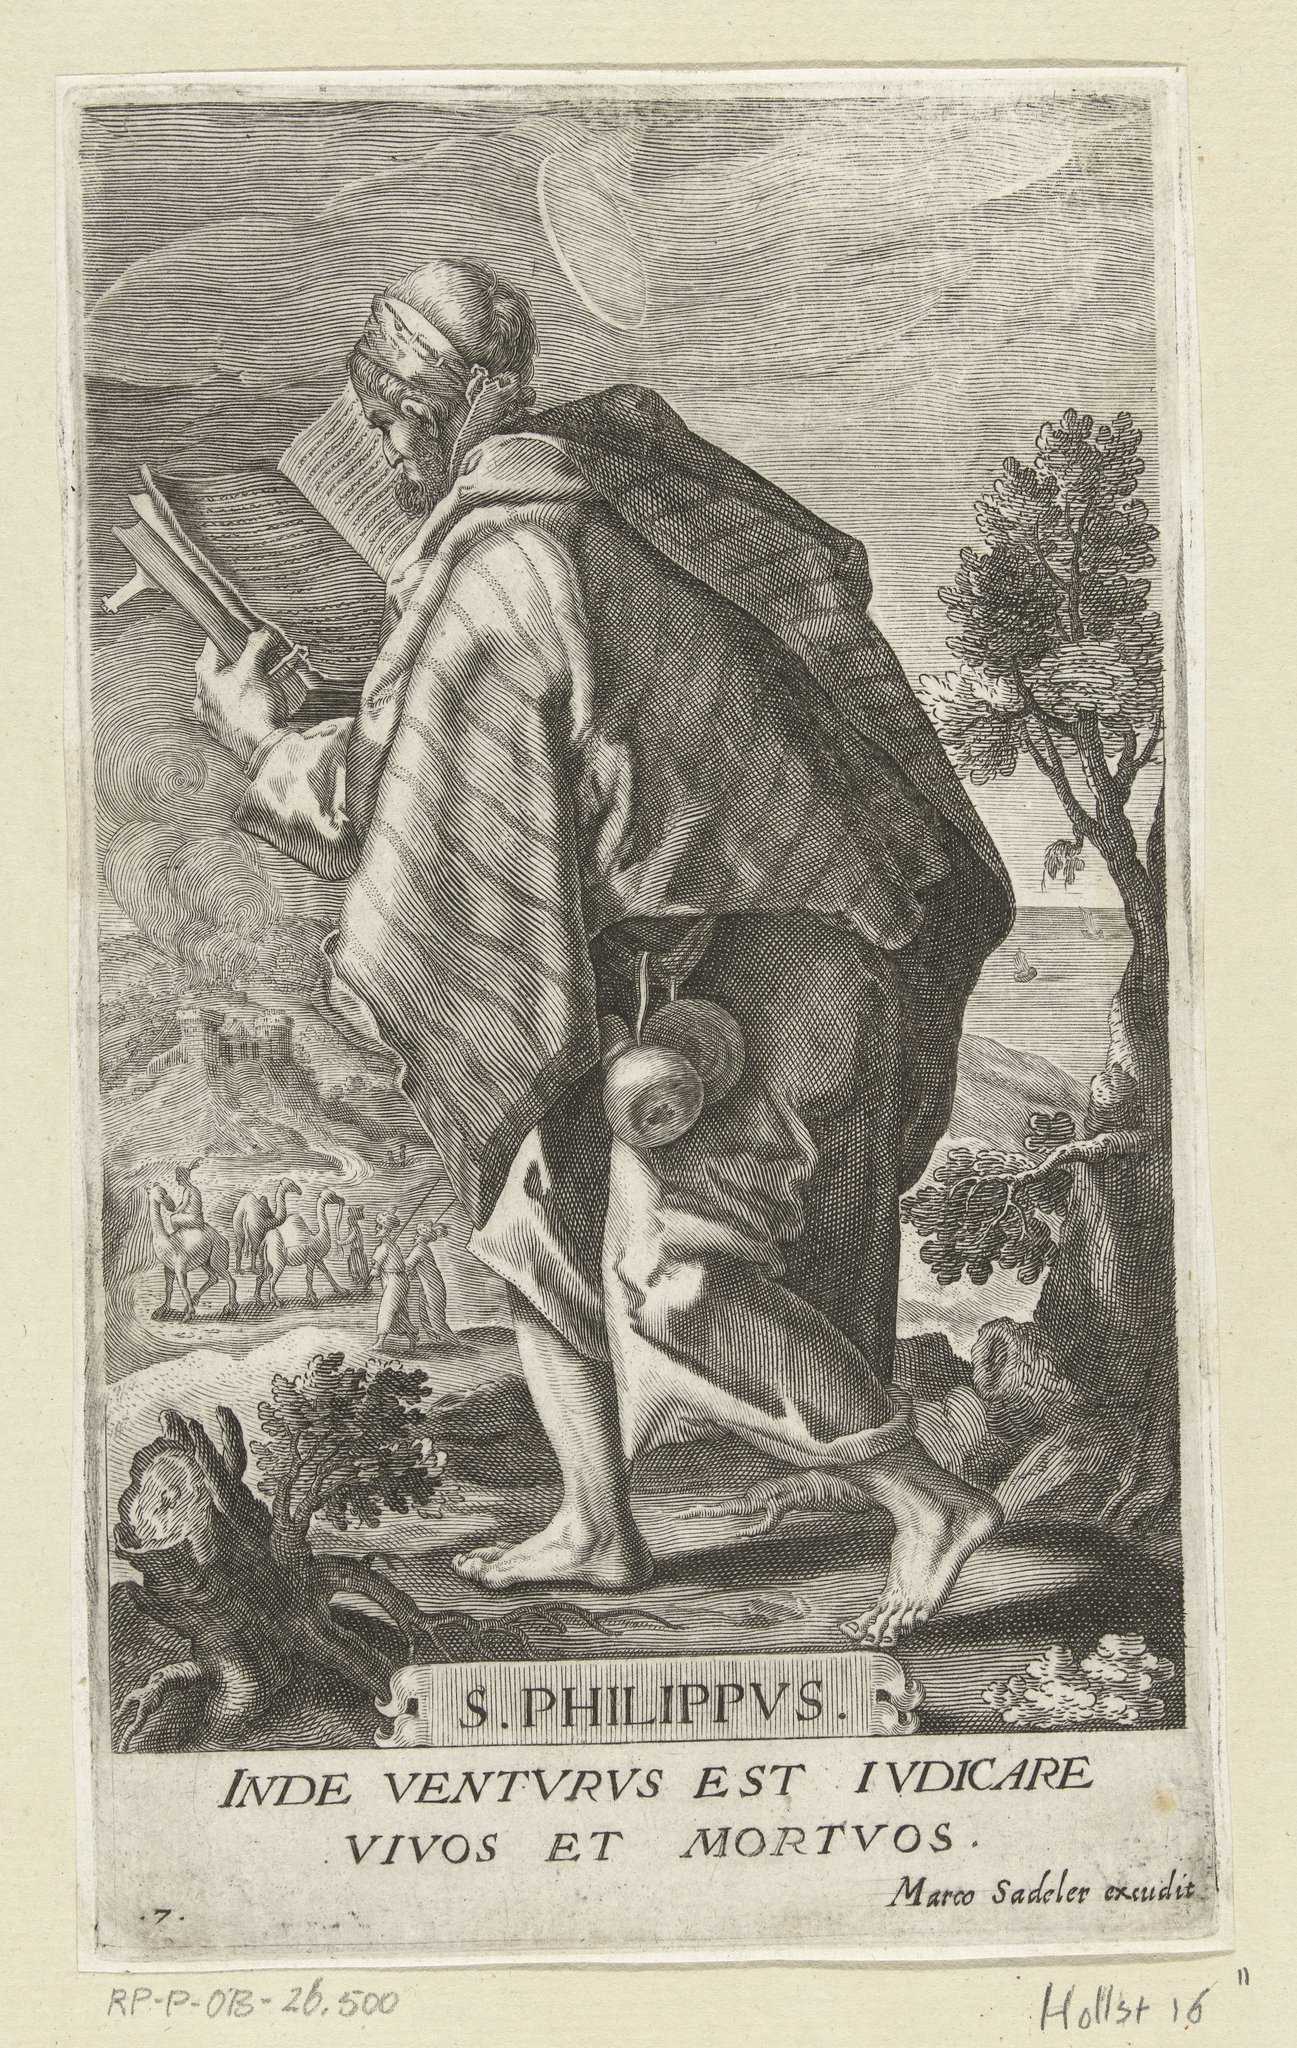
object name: print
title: S. Philippvs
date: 1591-1629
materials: paper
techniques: engraving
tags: the apostle philip; possible attributes: book, cross, dish with snake, lance, scroll, stone, sword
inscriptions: collector's mark: Lugt 240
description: Prent naar ontwerp van Joos van Winghe. Prent maakt deel uit van serie met dertien prenten en titelprent van Christus en twaalf apostelen.